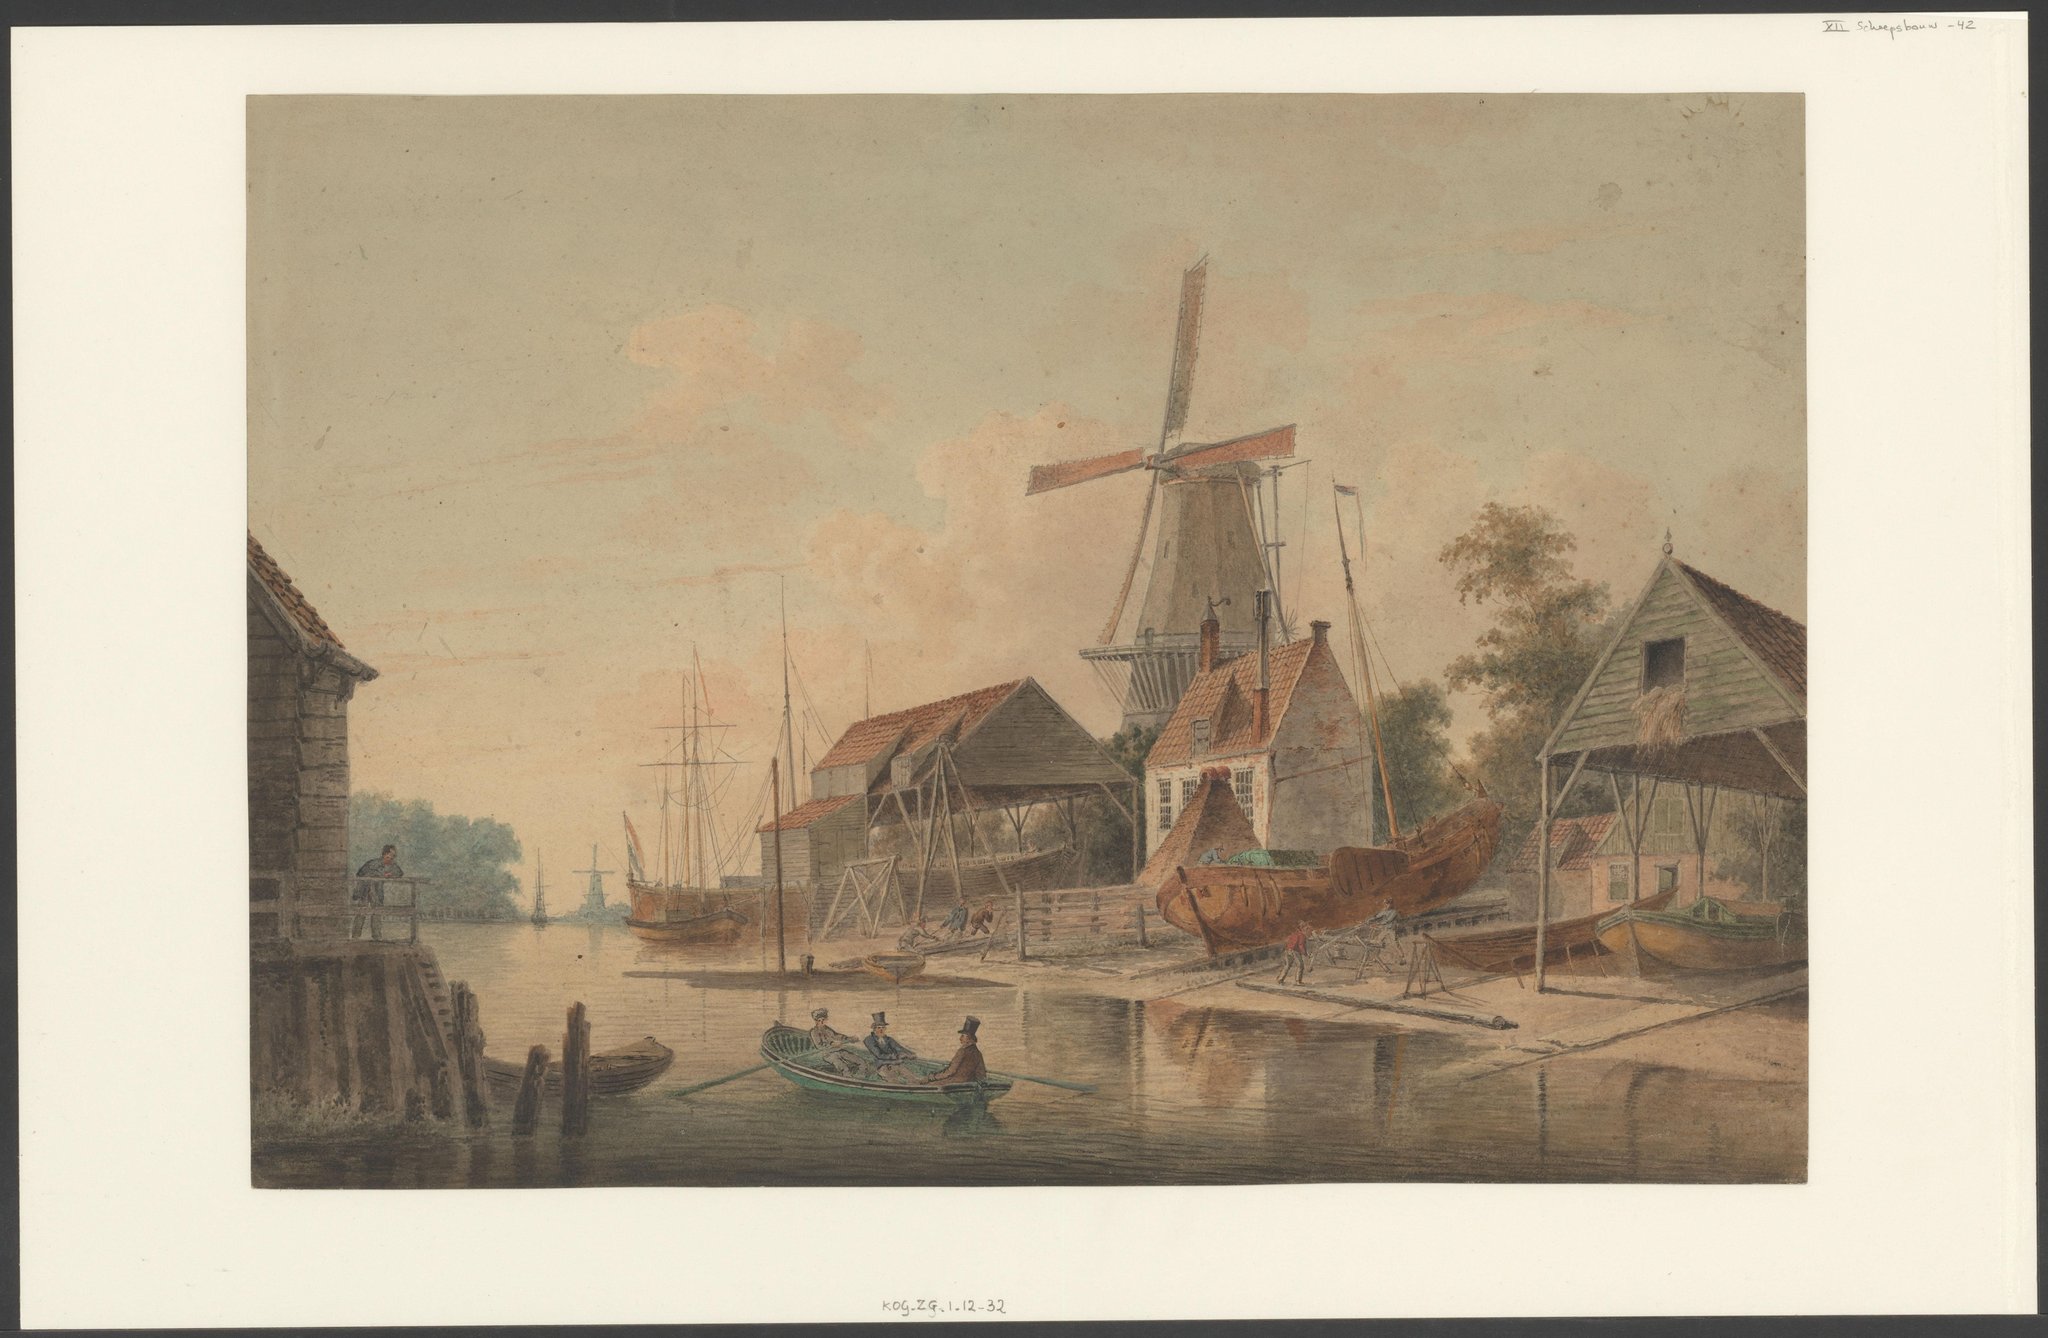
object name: drawing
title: Scheepswerf met molen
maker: j. van leeuwen (19de eeuw)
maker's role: draughtsman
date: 1800-1899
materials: paper, watercolor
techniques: brush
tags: sailing-ship, sailing-boat, repairing, caulking, careening (~ ship), rowing facing backward, pulling, windmill, harbouring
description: Onderwerpsrubrieken binnen de Atlas Zeden en Gewoonten: Handel, Nijverheid en Verkeer, Scheepsbouw.